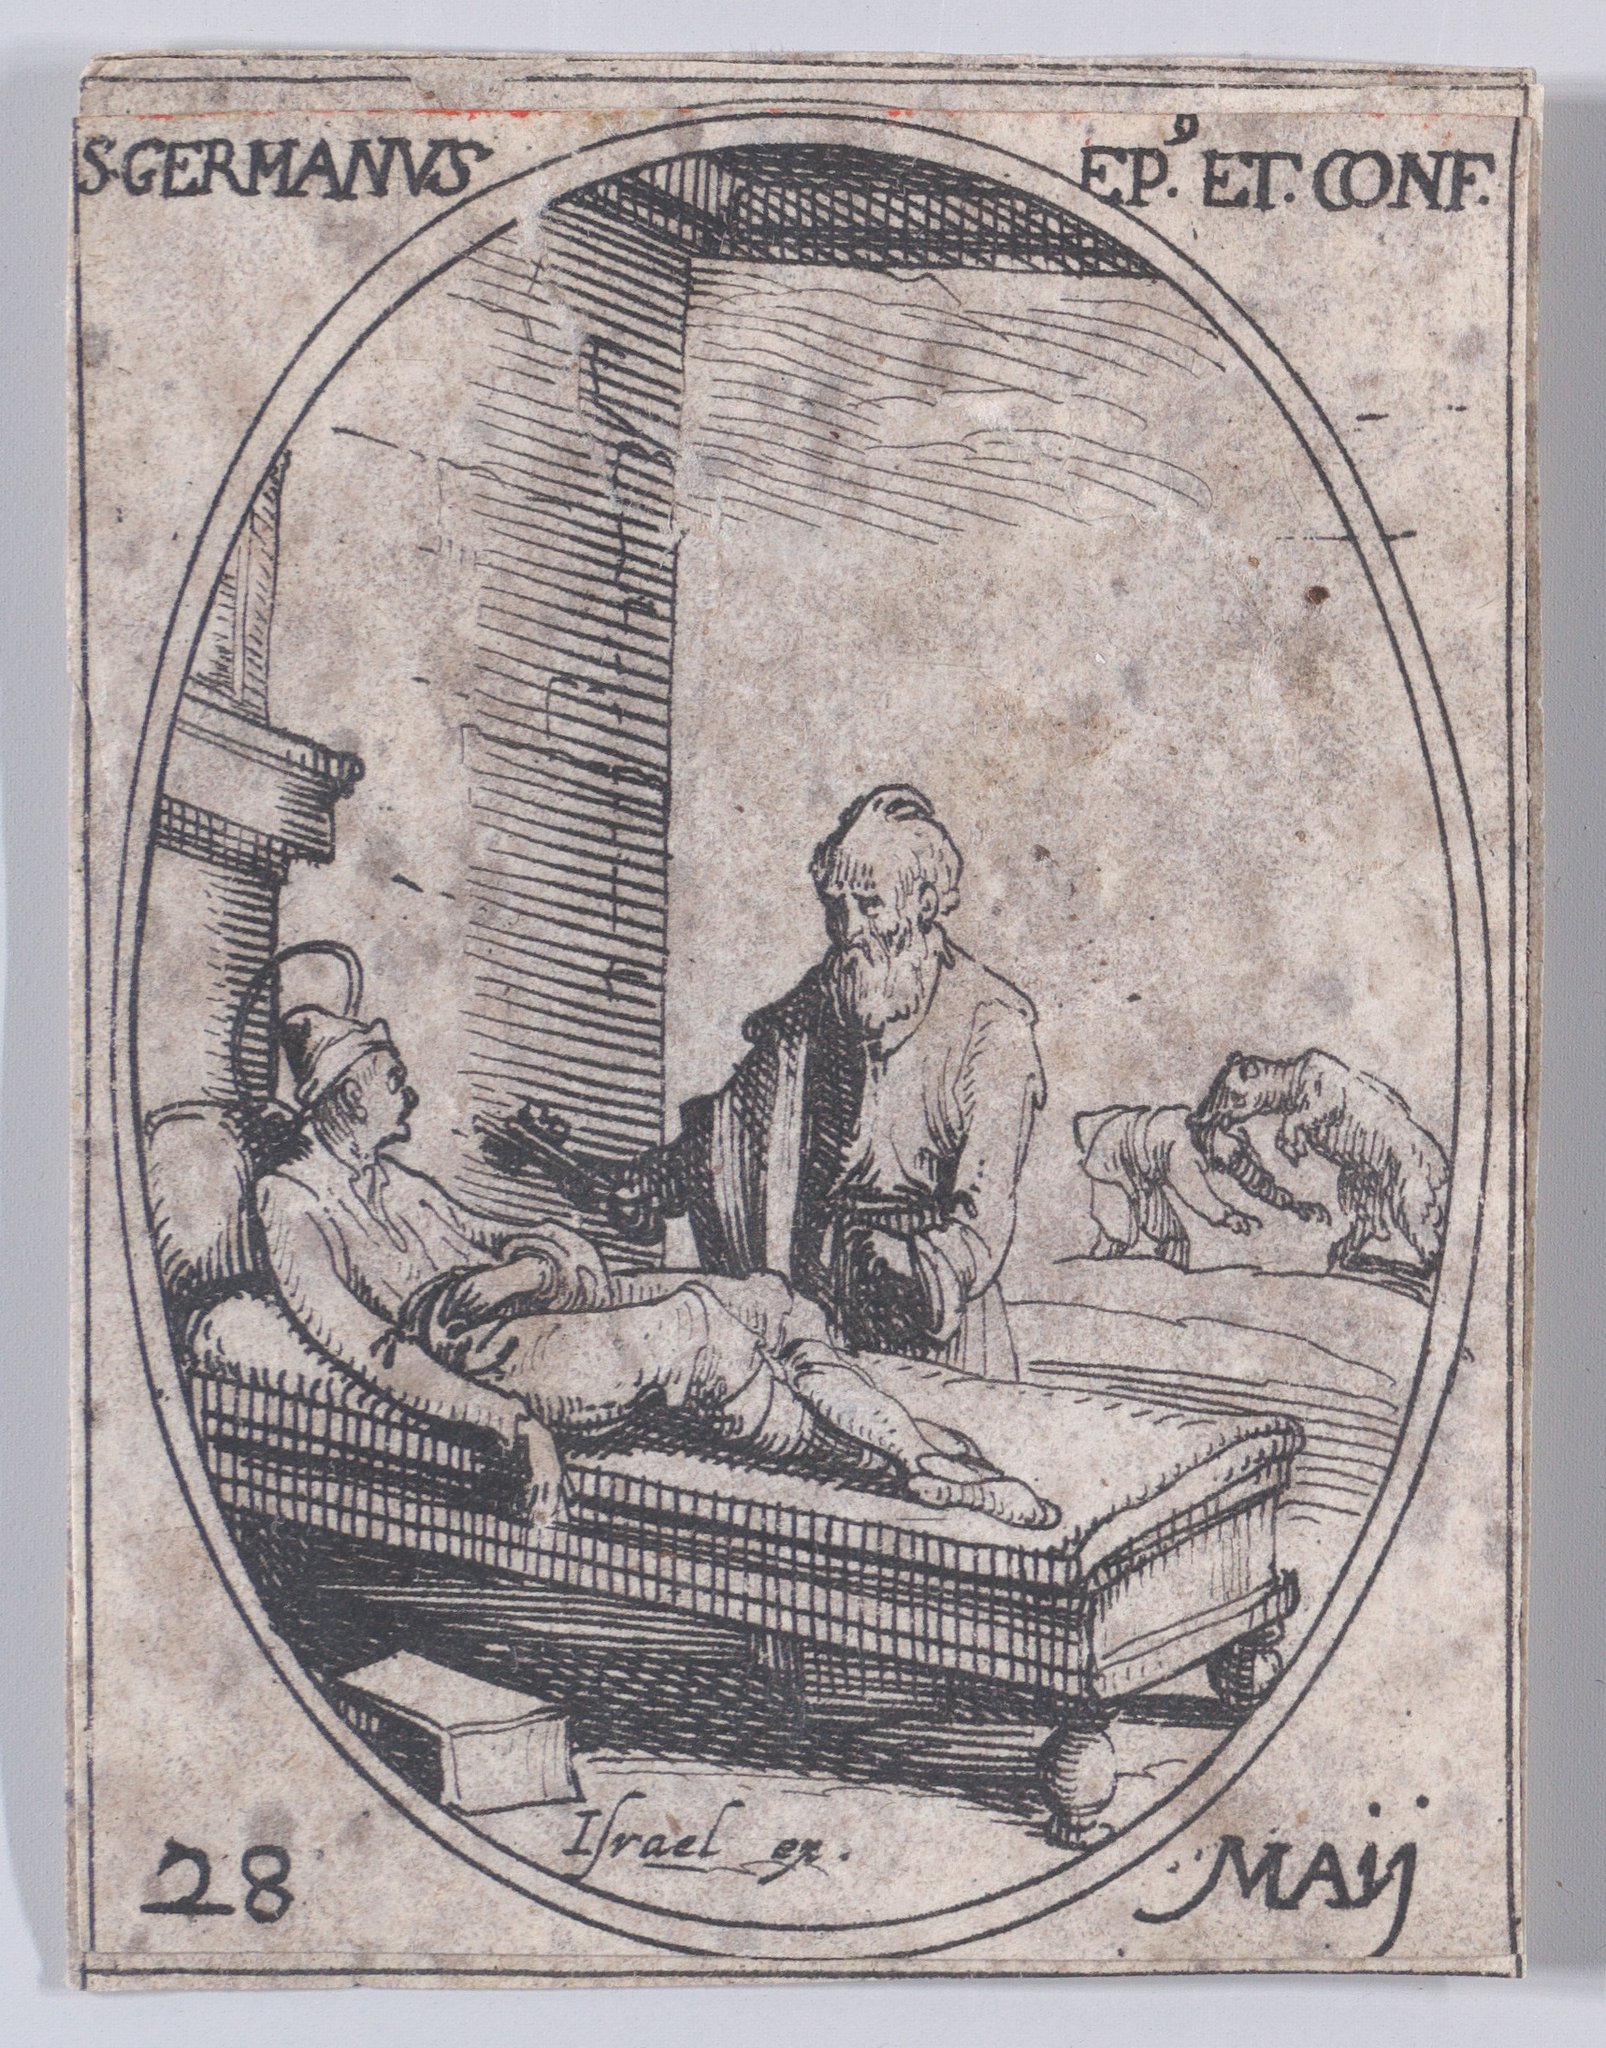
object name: print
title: S. Germain, évêque et confesseur (St. Germanus, Bishop and Confessor), May 28th, from "Les Images De Tous Les Saincts et Saintes de L'Année" (Images of All of the Saints and Religious Events of the Year)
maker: jacques callot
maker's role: artist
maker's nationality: french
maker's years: 1592-1635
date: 1636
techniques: etching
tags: men,saints